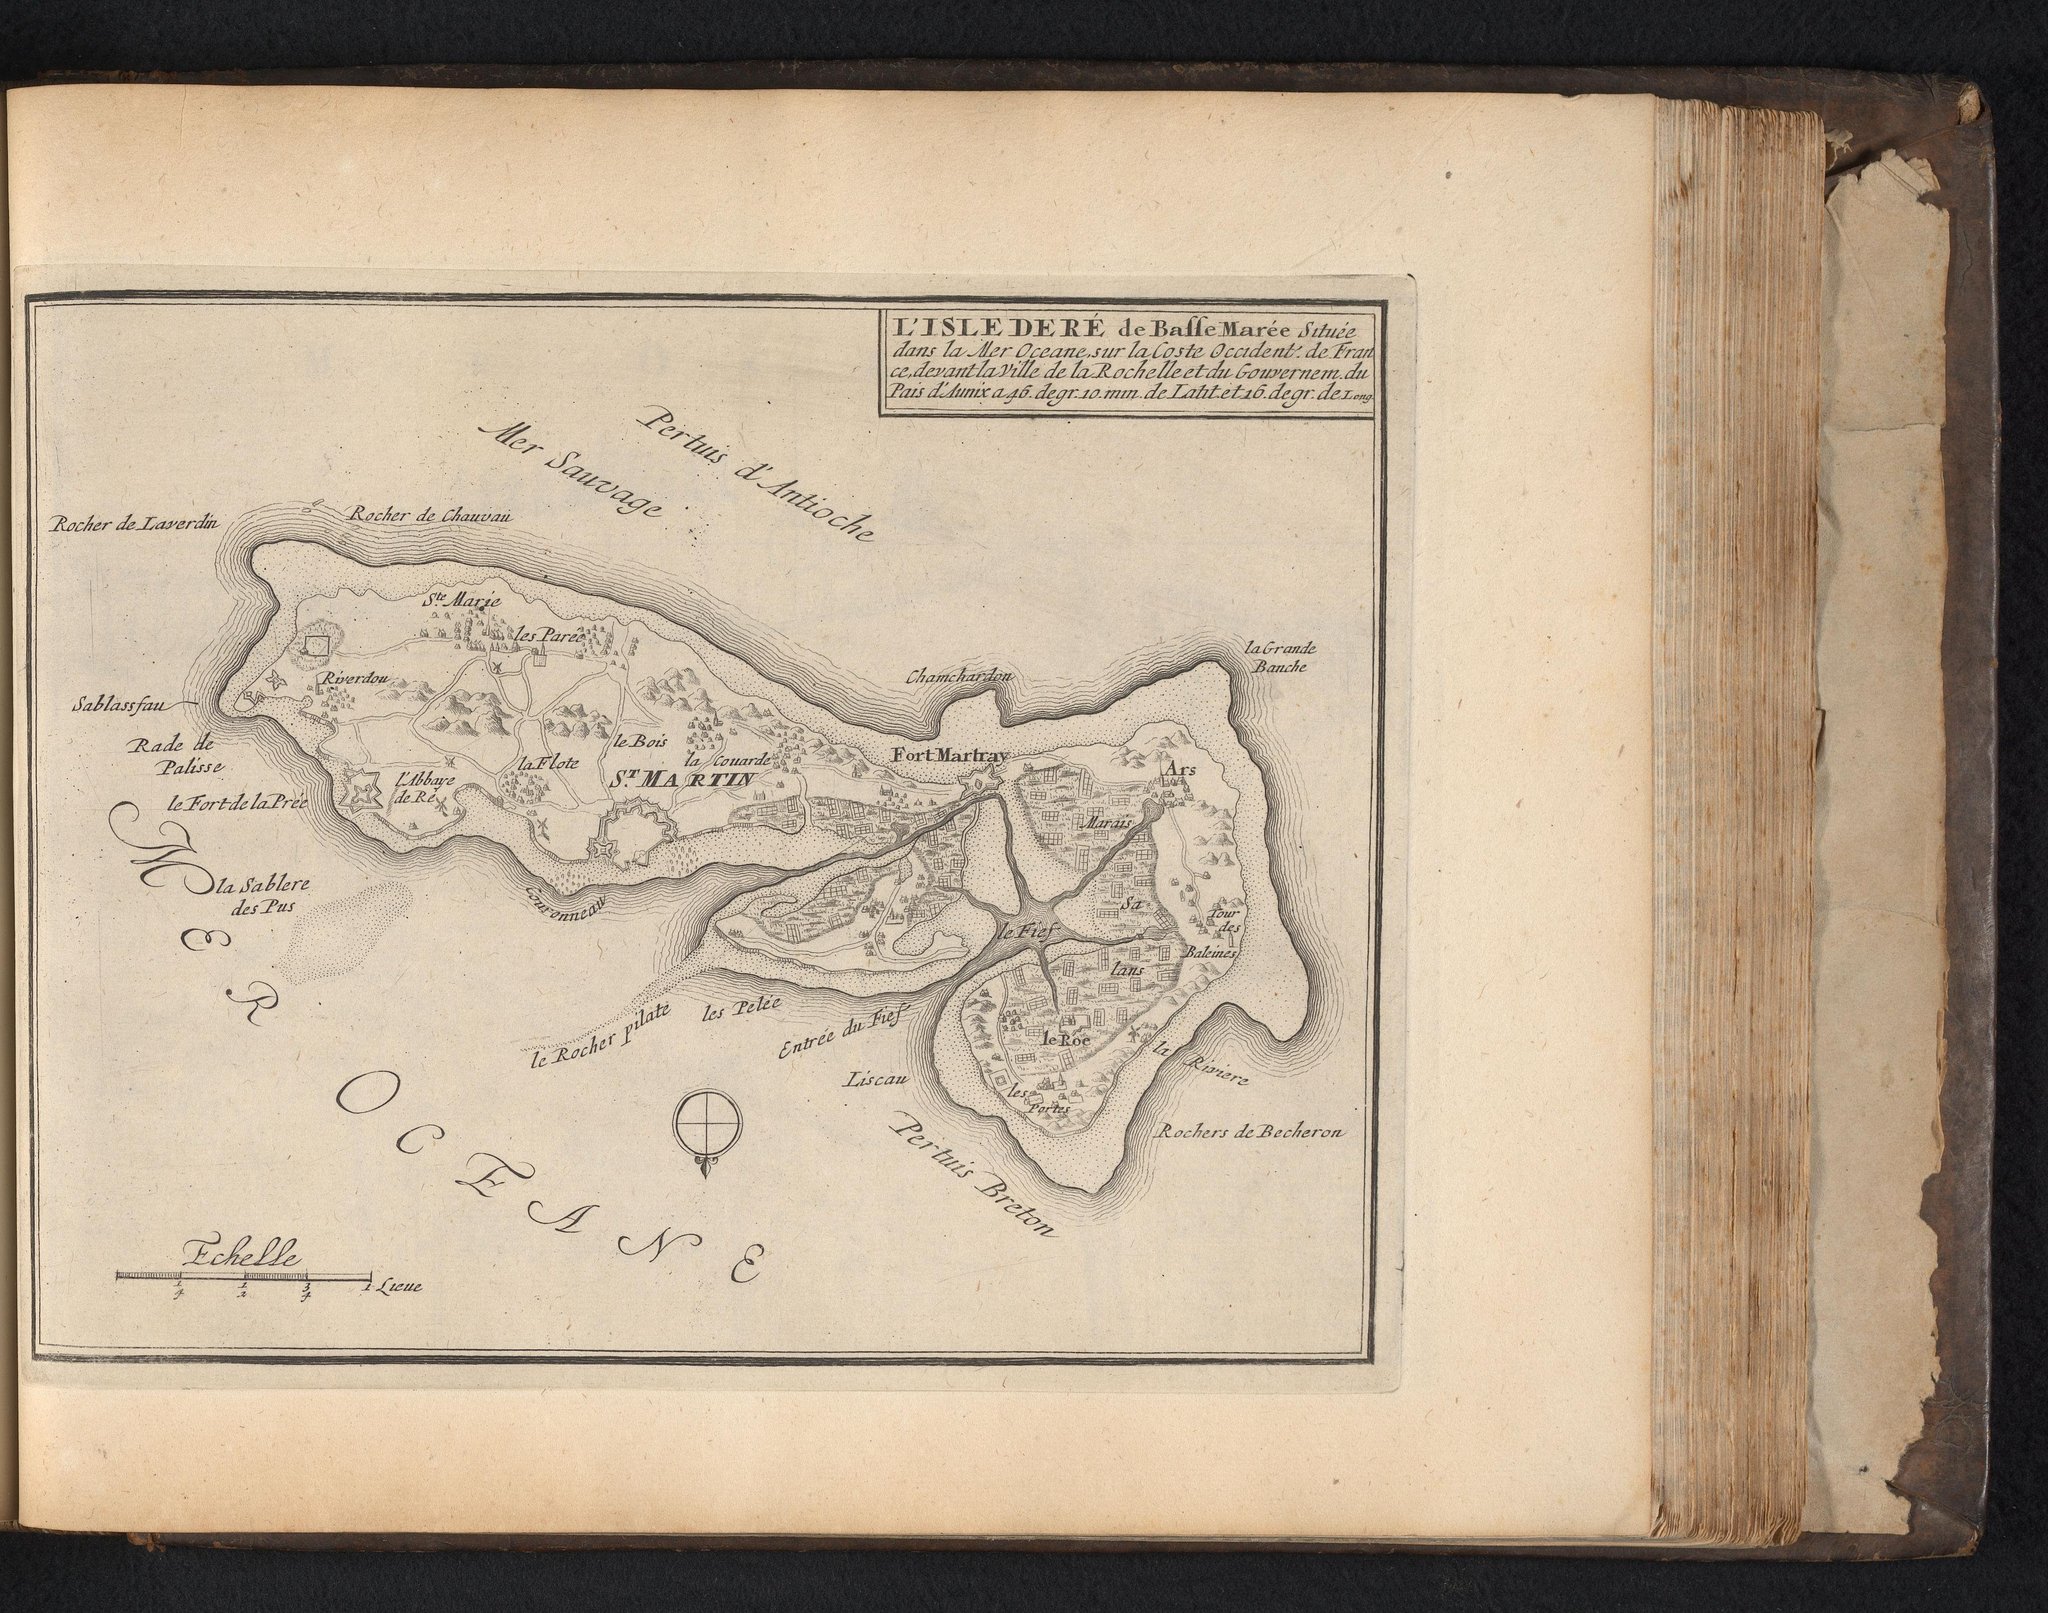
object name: map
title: Les forces de l'Europe, ou description des principales villes, avec leurs fortifications : dessignées par les meilleurs ingenieurs, particulierement celles (...) de la France, dont les plans ont esté levez par M. de Vauban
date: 1695-1697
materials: paper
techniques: etching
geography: france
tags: maps of separate countries or regions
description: Kaart van het eiland Ile de Ré voor de Franse kust bij de stad La Rochelle. Onderdeel van het achtste deel (1697) van het prentwerk waarin gebundeld zijn de acht delen van Les forces de l'Europe uitgegeven tussen 1693-1697. Het prentwerk bestaat uit 175 platen met plannen (afkomstig van Sébastien Le Prestre, Seigneur de Vauban) van vermaarde sterke steden en vestingen in de Negenjarige Oorlog. Titel en opschriften in het Frans.